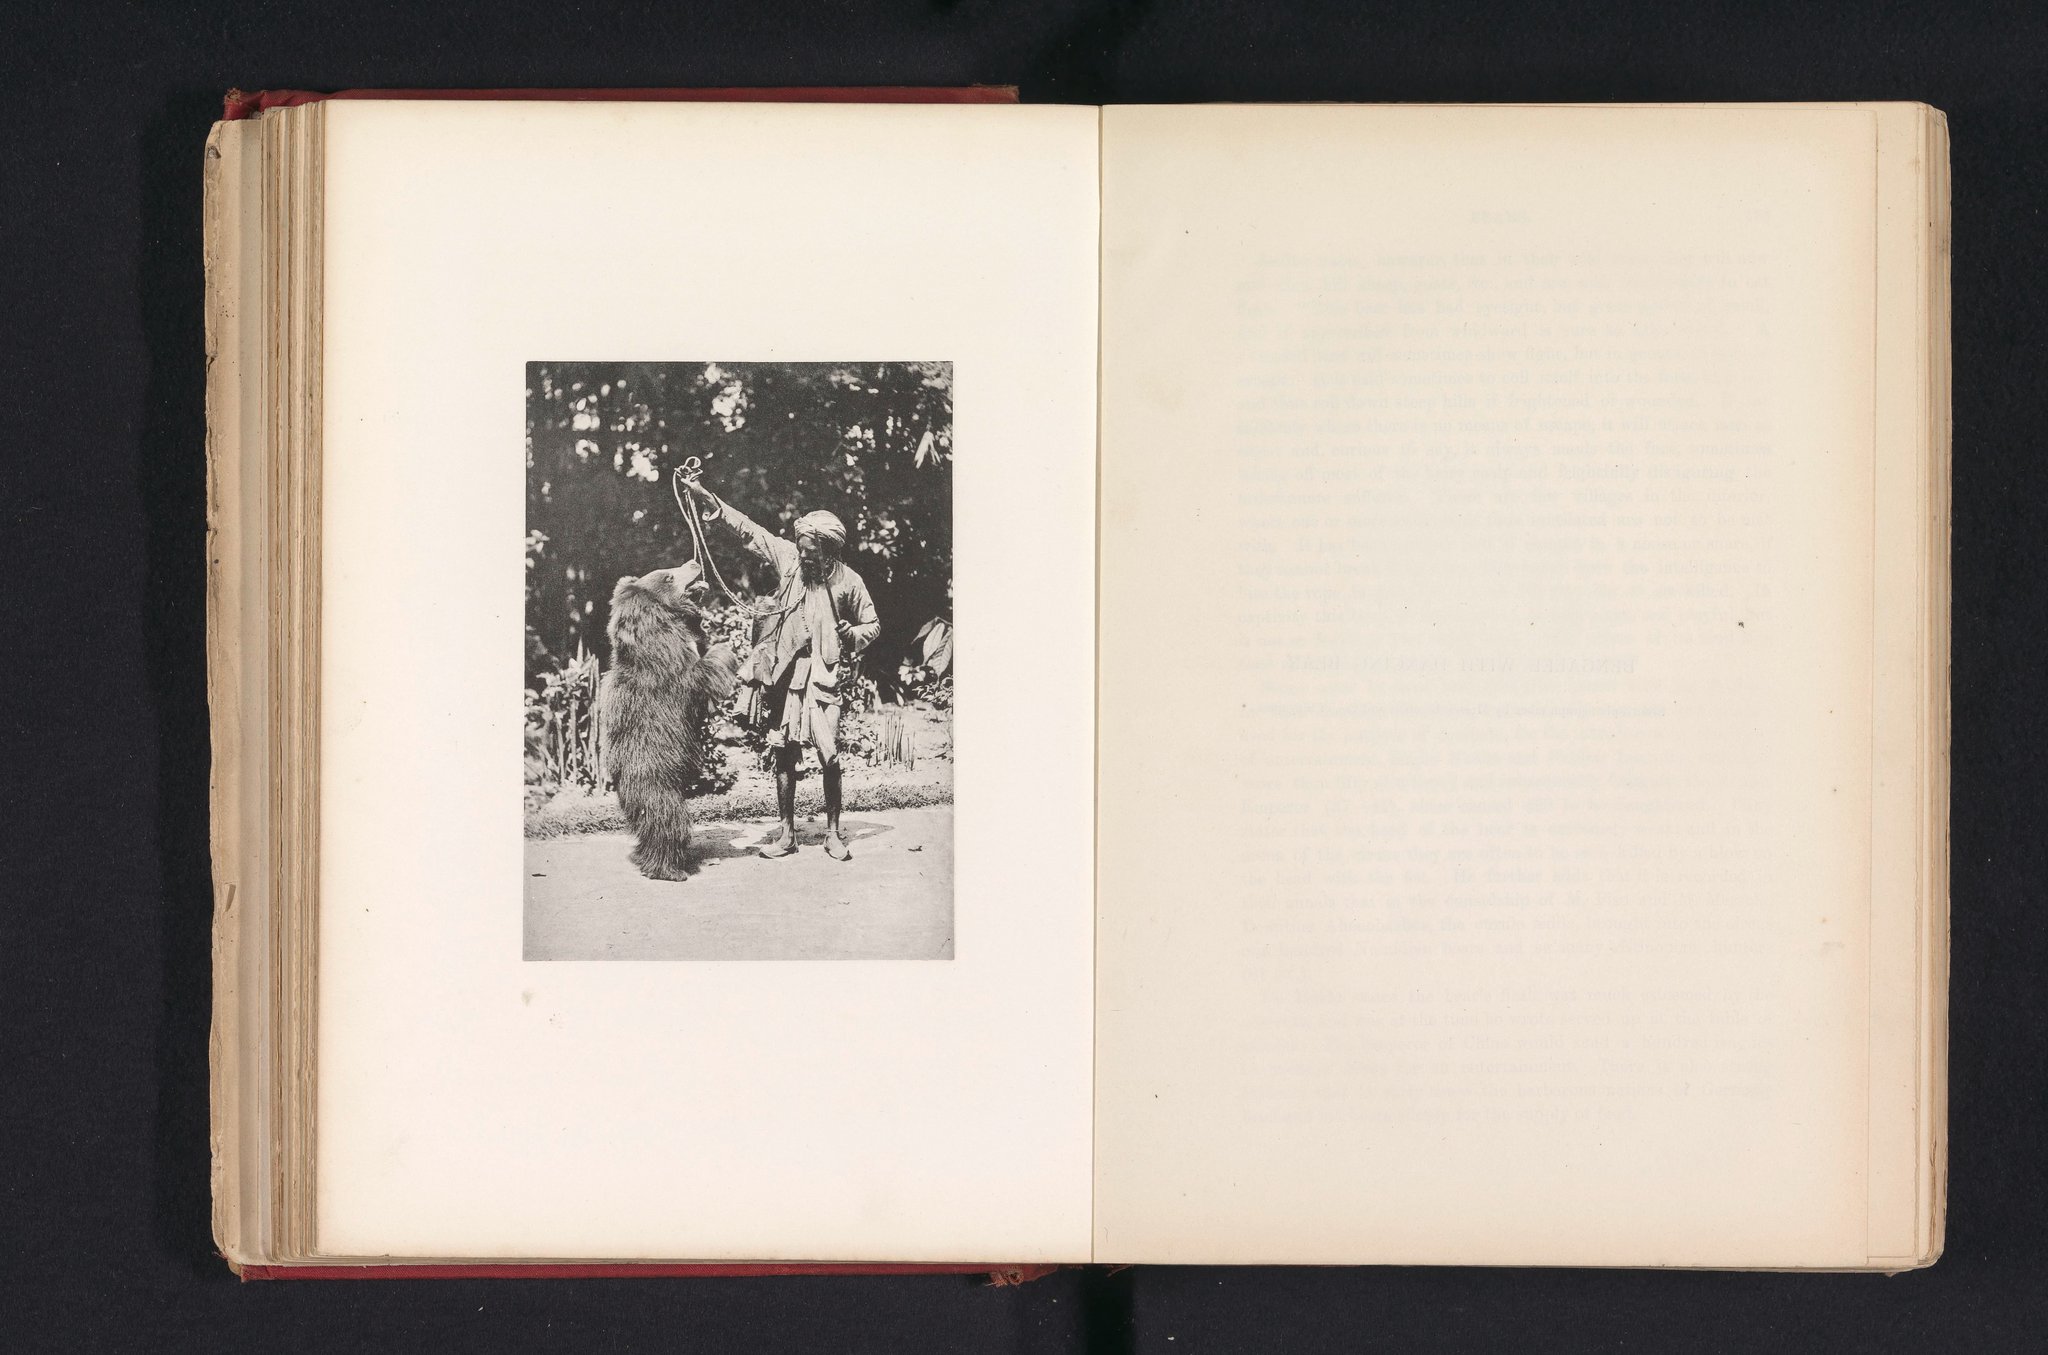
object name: photomechanical print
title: Bengalee with dancing bear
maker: Anonymous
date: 1876-1886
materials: paper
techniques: photograph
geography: paris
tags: bears (circus performance)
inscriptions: inscription: ‘From a photograph taken by Messrs. Lambert and Co., of Singapore.’